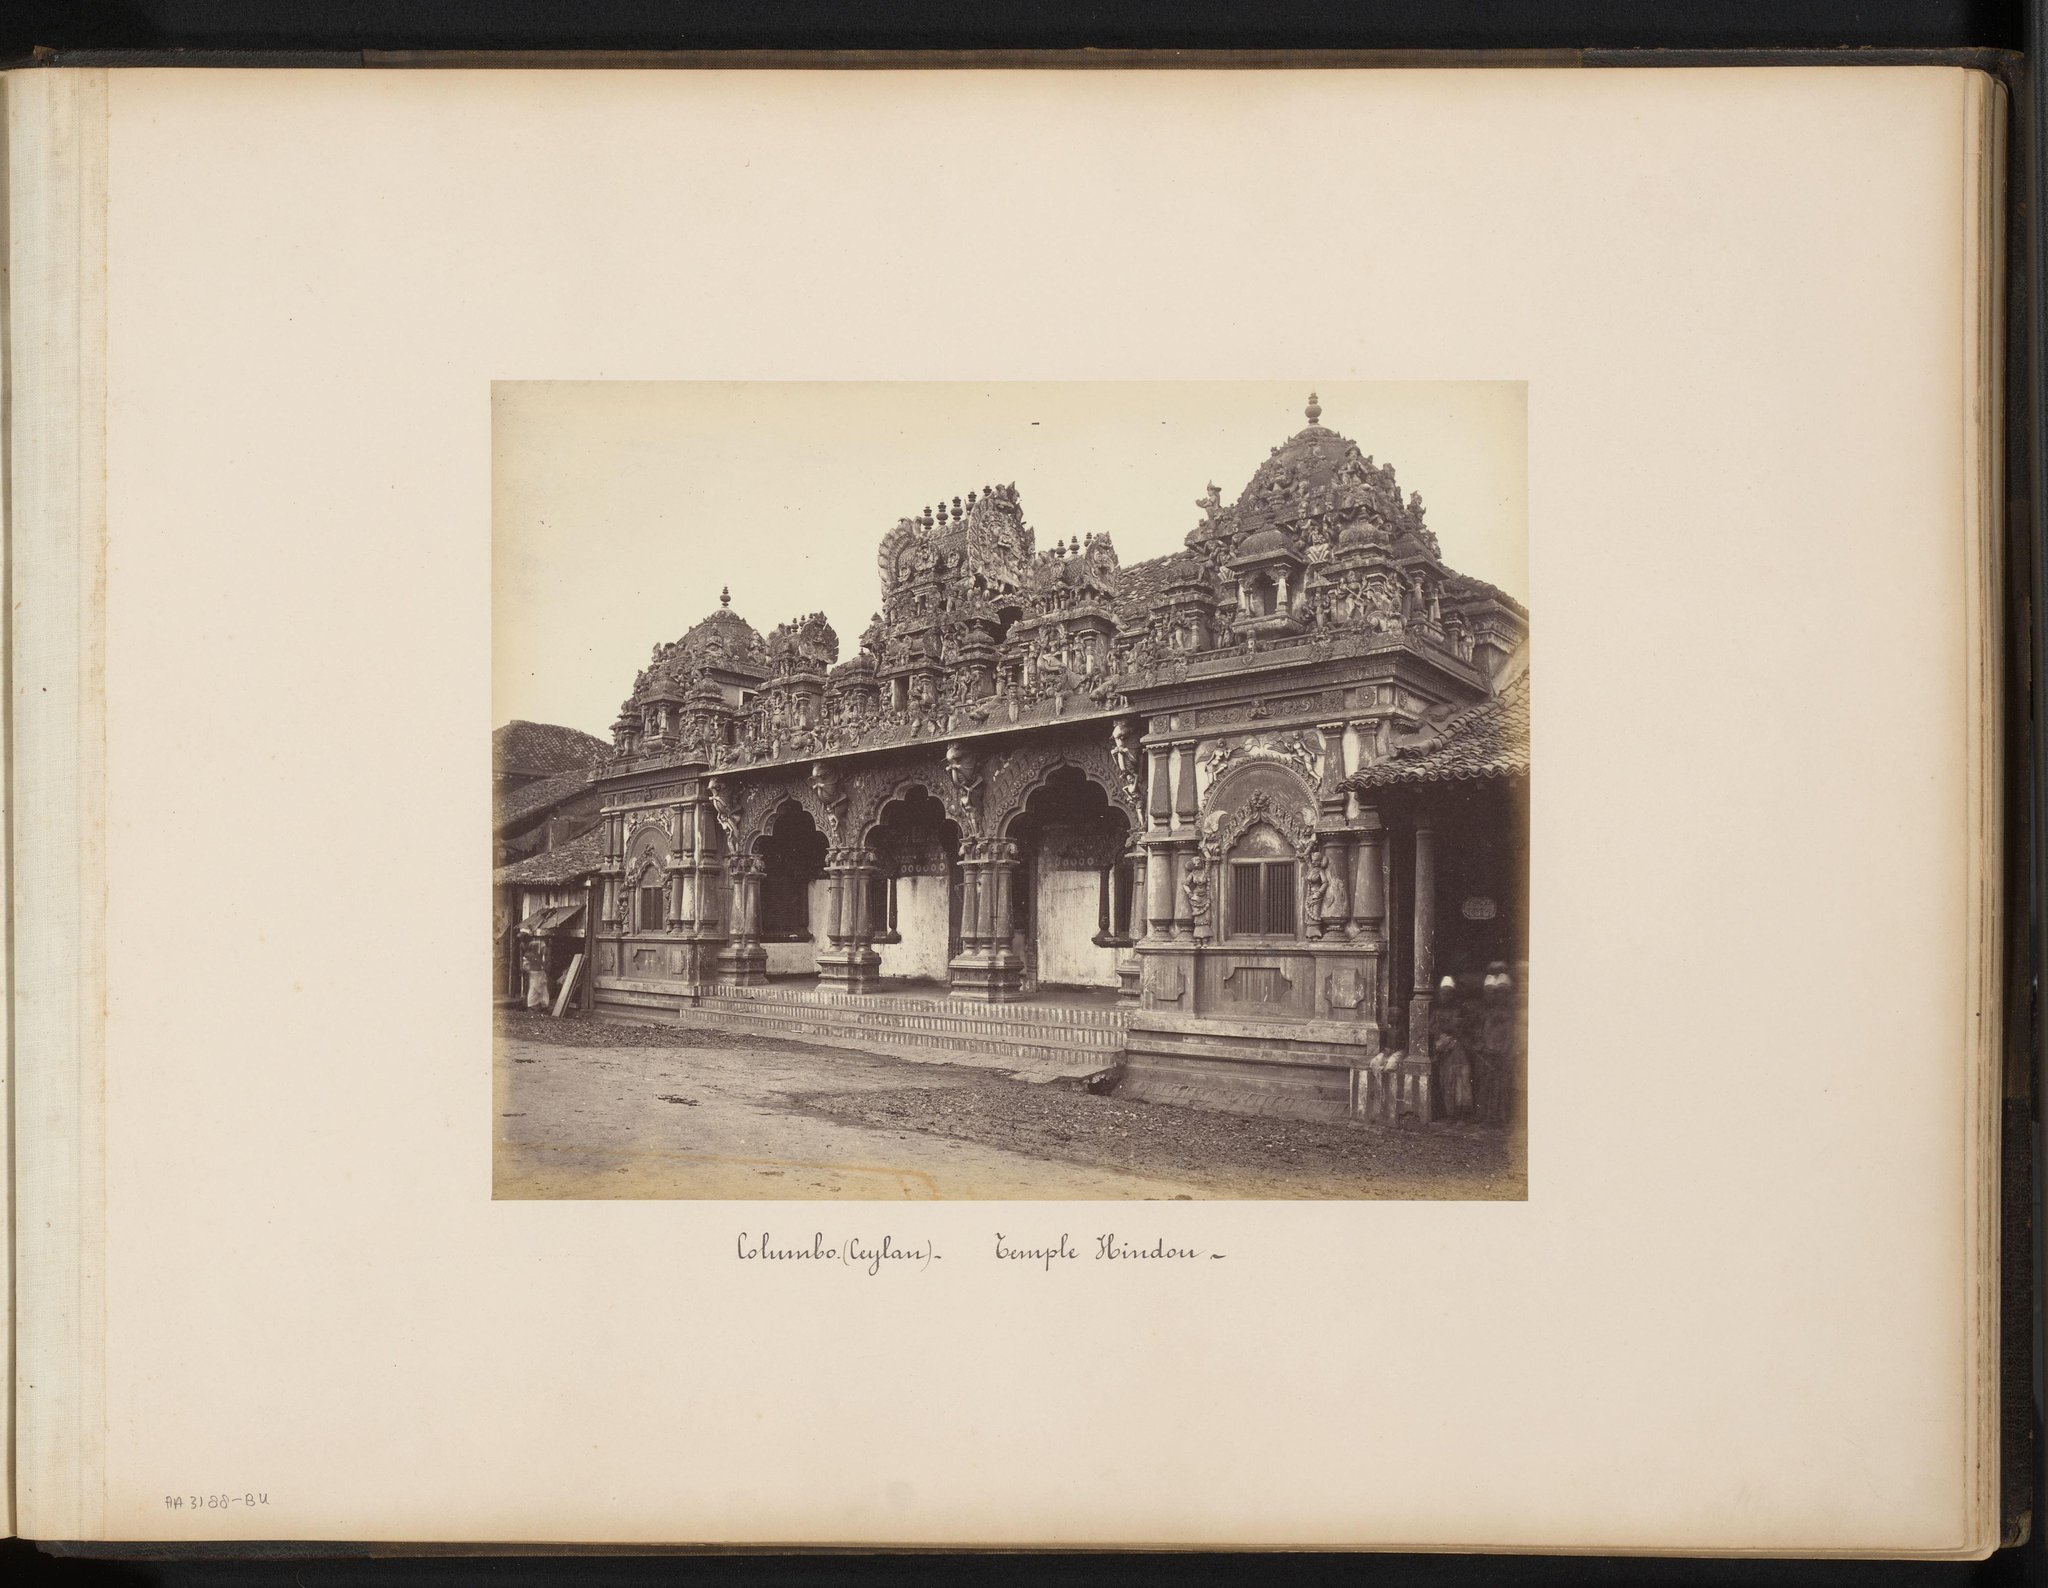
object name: photograph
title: Exterior of a Hindu temple on the Sea Street, Colombo, Sri Lanka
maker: Anonymous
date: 1880-1883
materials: photographic support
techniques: albumen print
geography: colombo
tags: temple, shrine ~ hinduism, buddhism, jainism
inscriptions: title: ‘Columbo. (Ceylan) _ Temple Hindou _’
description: Onderdeel van Reisalbum met opnames van bezienswaardigheden in Egypte, Nederlands-Indië, Singapore en Ceylon.